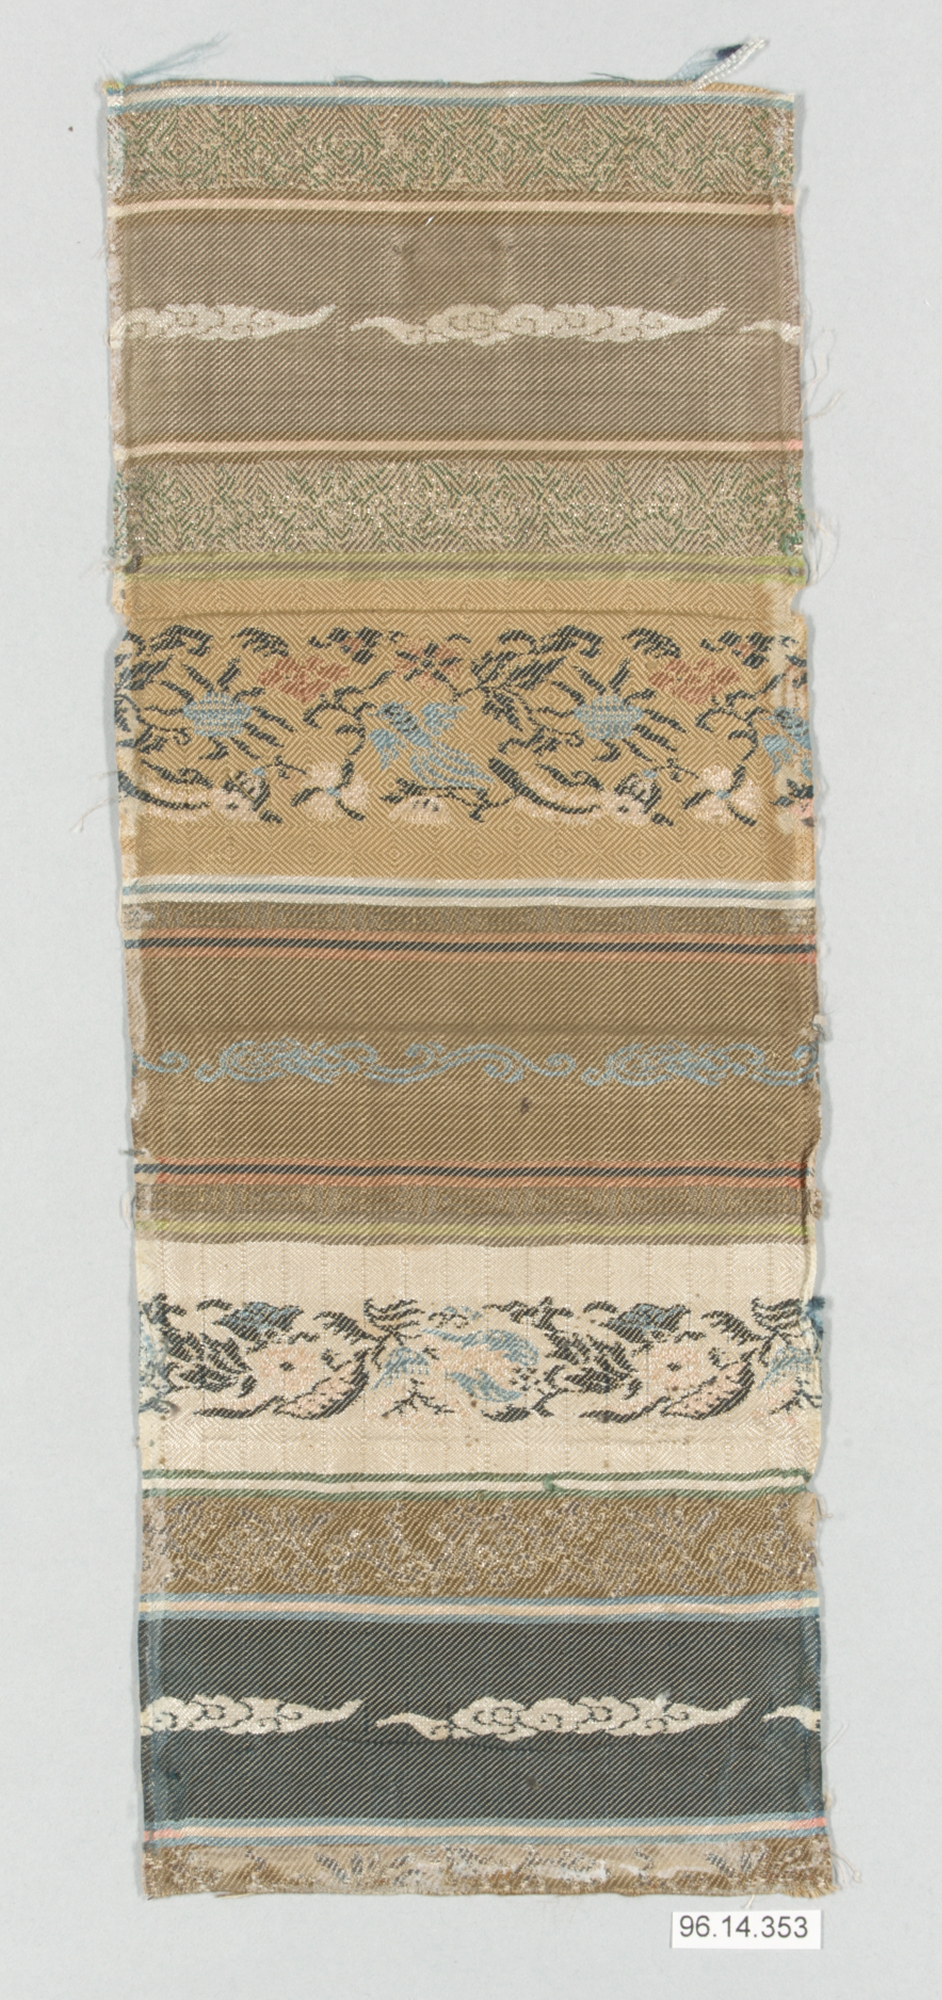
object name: piece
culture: japanese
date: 1701-1900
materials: silk